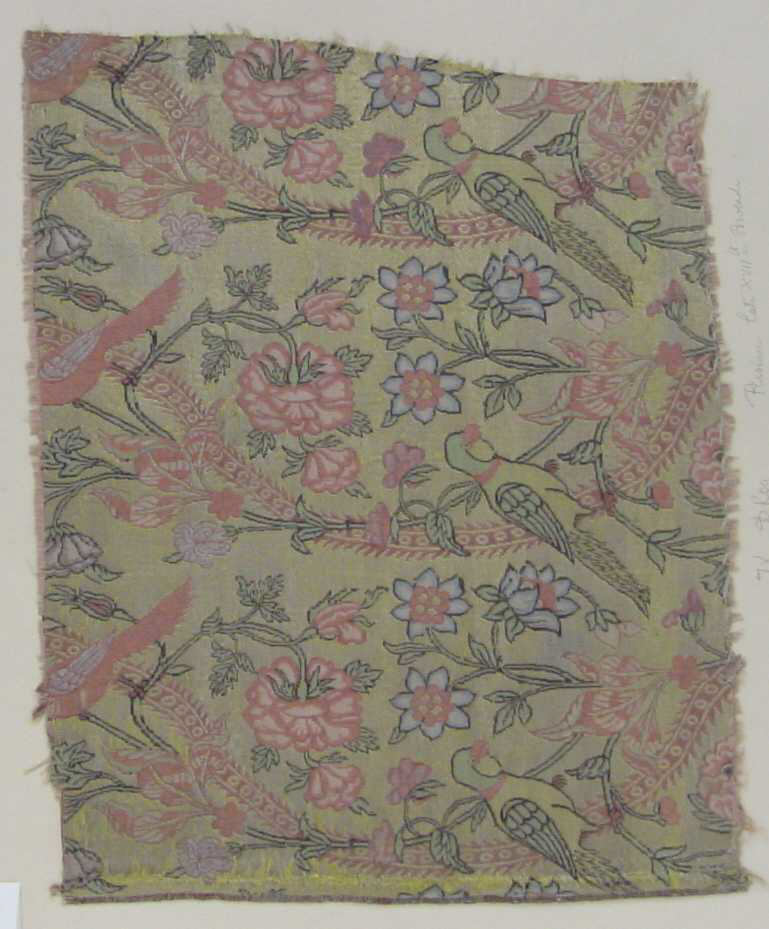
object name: textile fragment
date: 1601-1700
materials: metal thread, silk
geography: iran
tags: birds,flowers,leaves